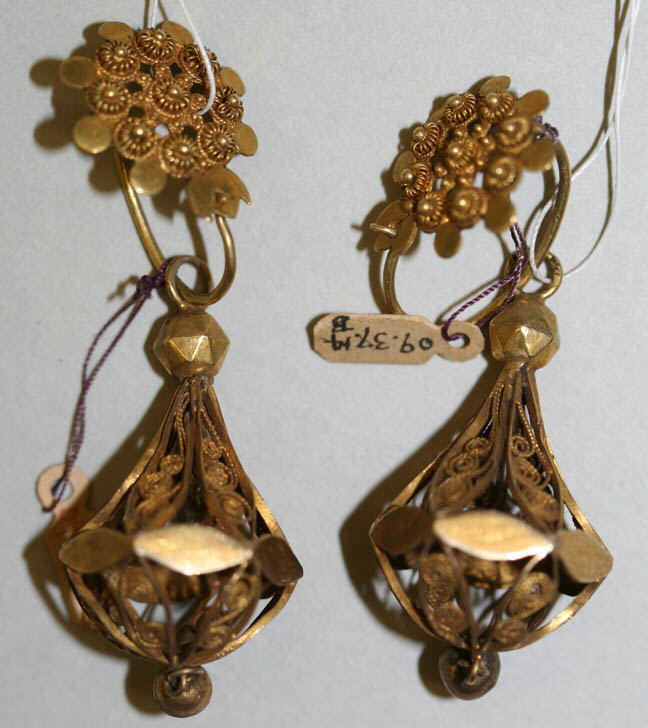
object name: earring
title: Earrings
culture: european, eastern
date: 1701-1900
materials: metal